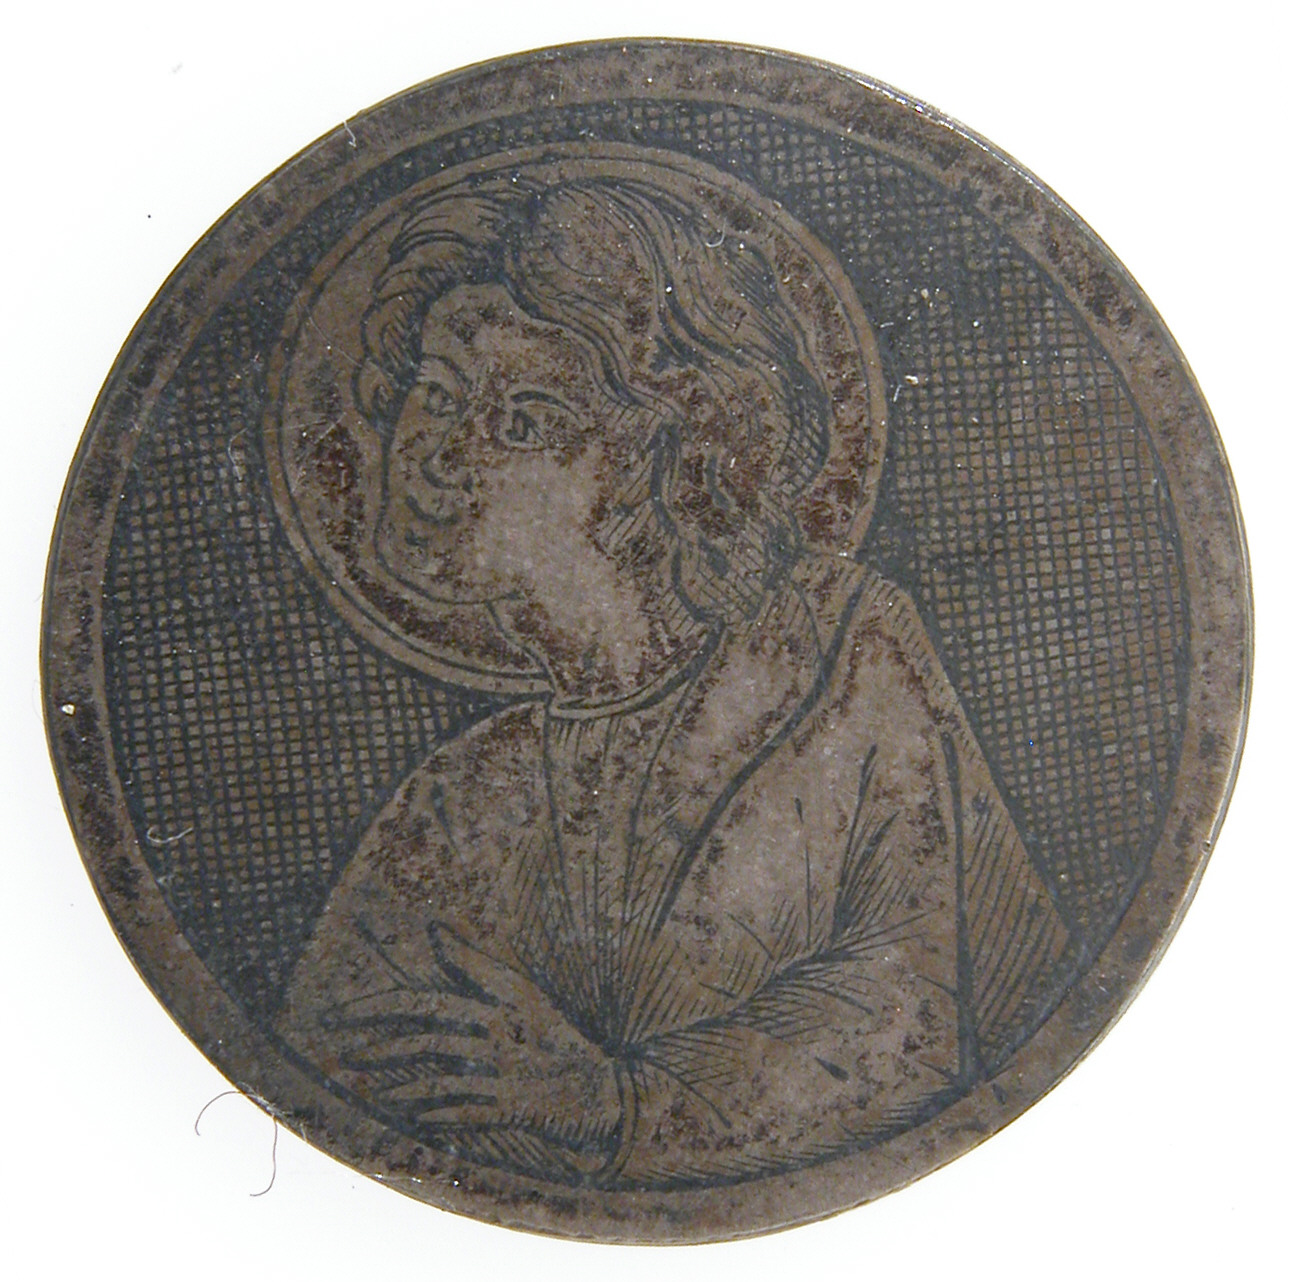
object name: plaque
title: Plaquette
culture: italian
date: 1401-1500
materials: niello, silver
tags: women